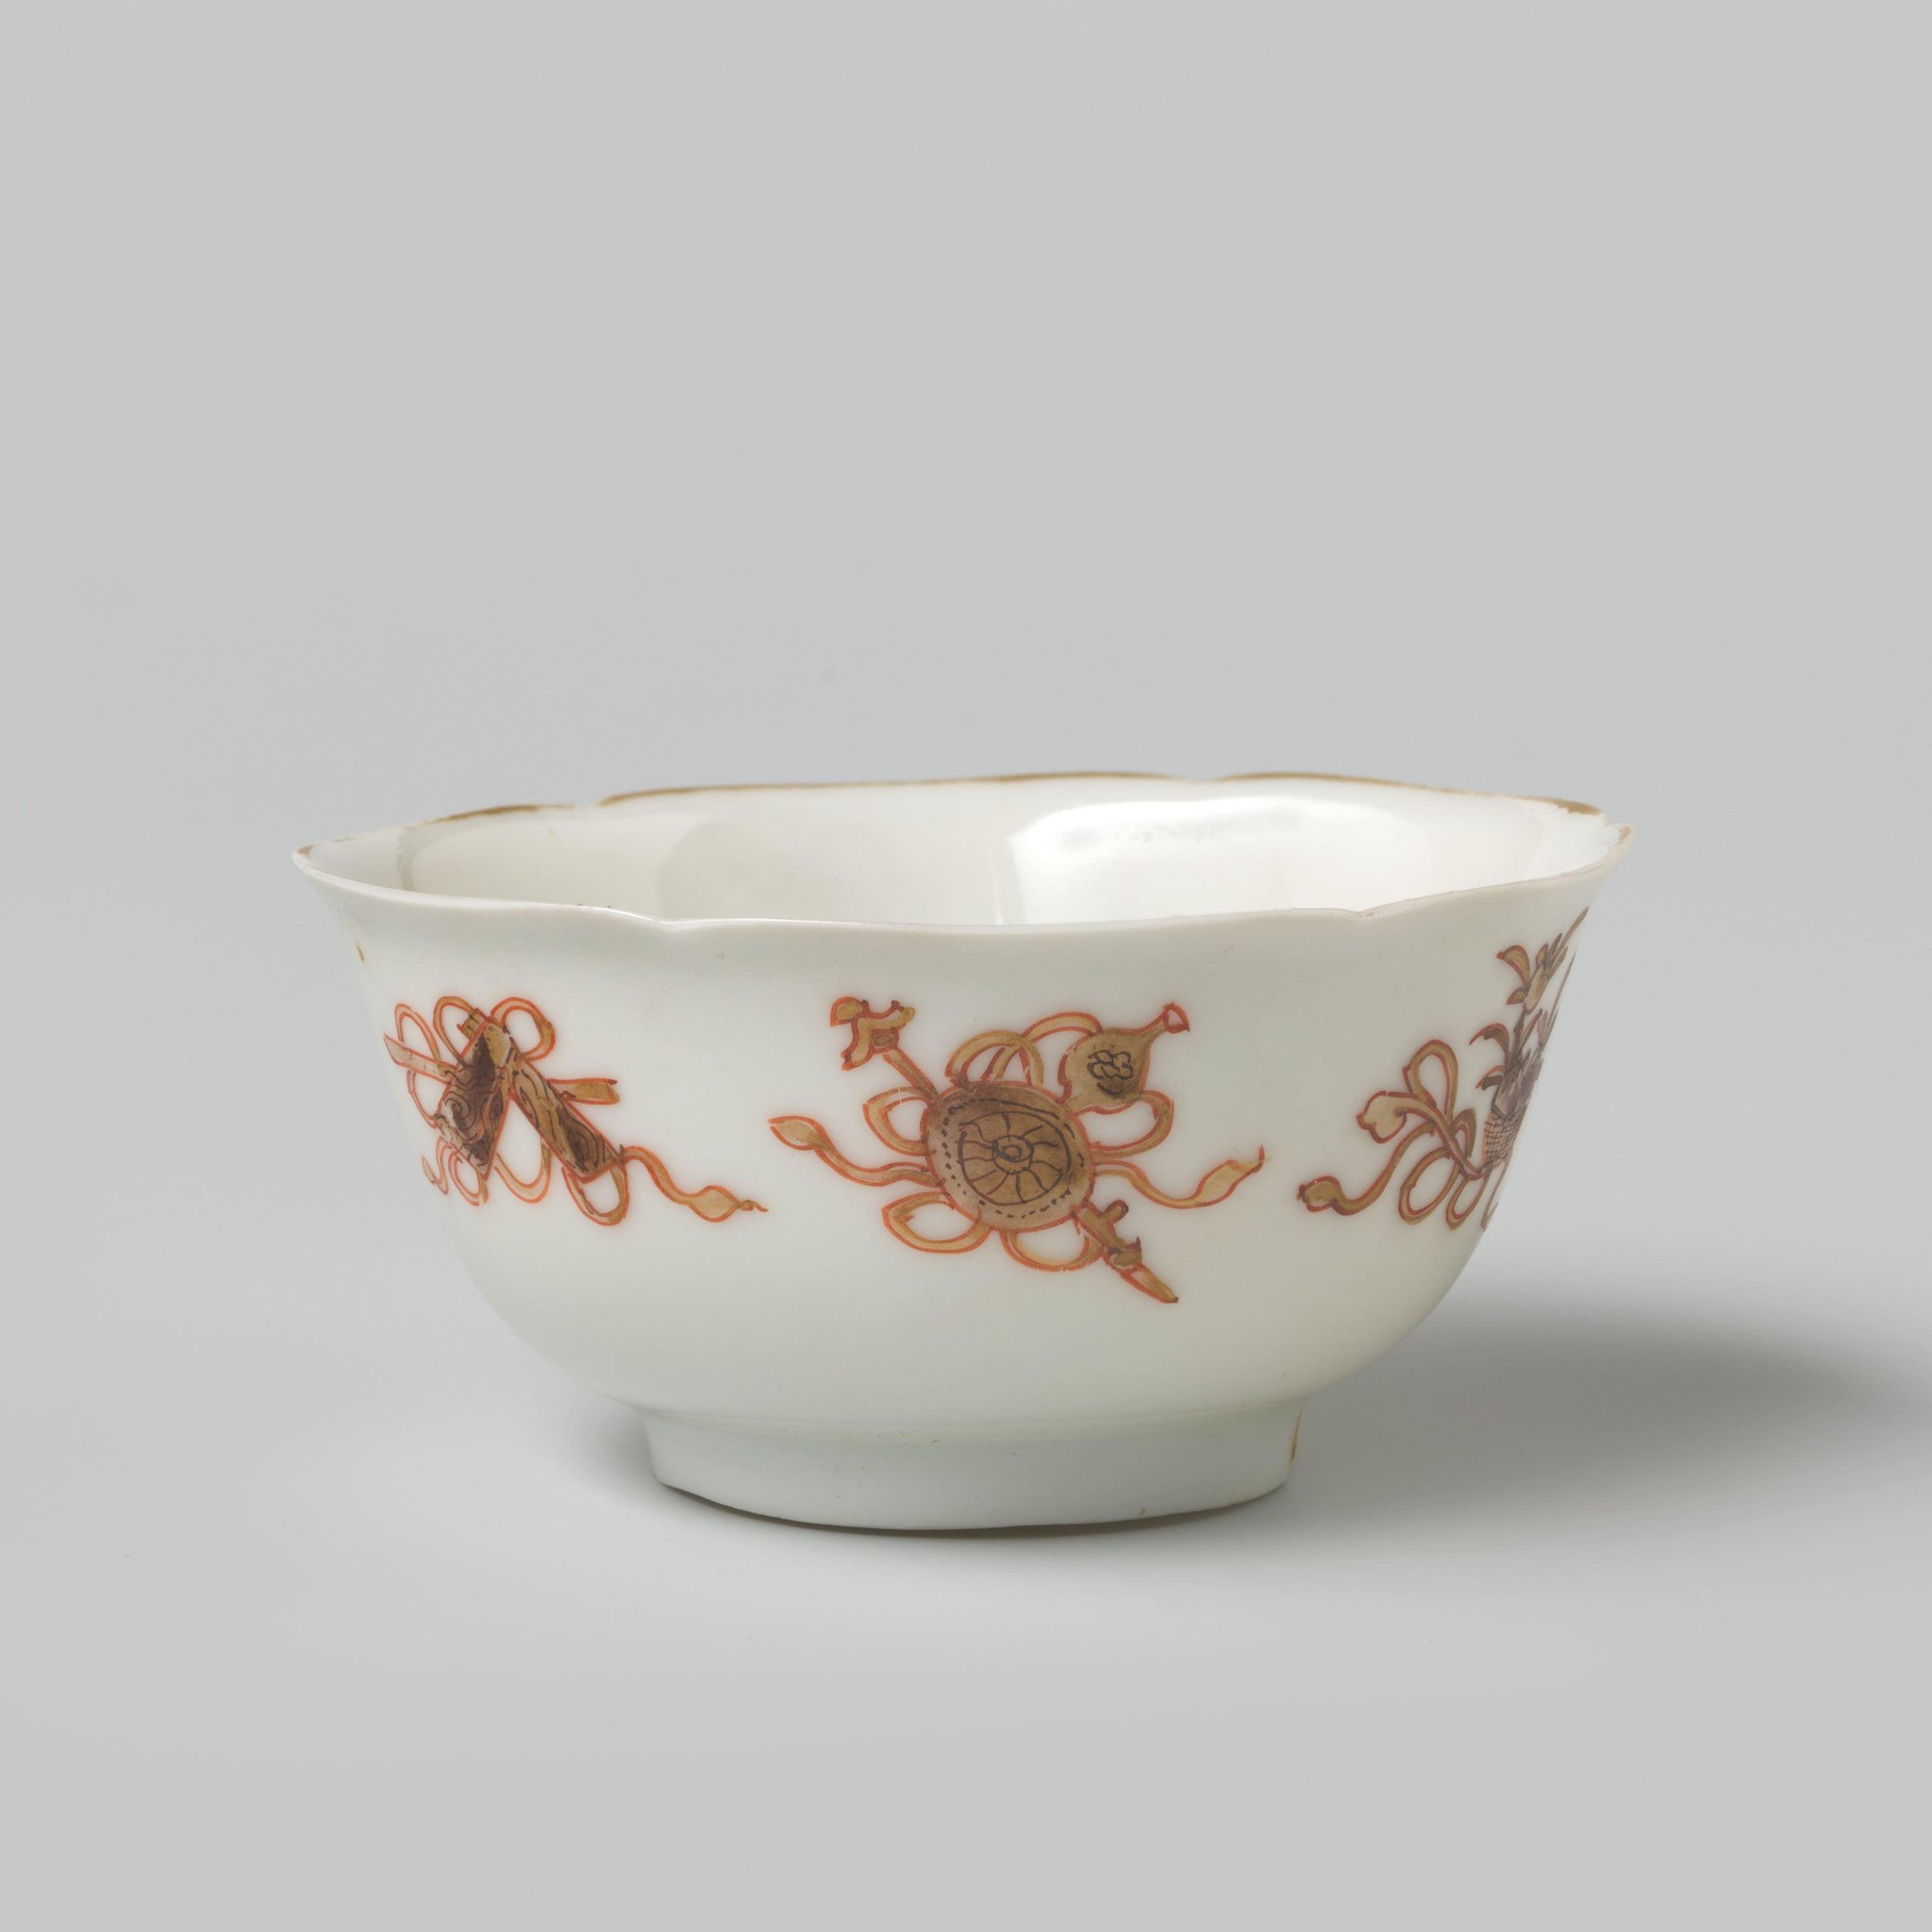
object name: cup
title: Cup with taoist symbols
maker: Anonymous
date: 1700-1724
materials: glaze, paint, porcelain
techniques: firing, gilding, turning, vitrification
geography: china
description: Kop van porselein met zesmaal gelobde rand, beschilderd op het glazuur in rood en goud. Een bloemenmand met paddestoelen (lingzhi), hieromheen de acht taoïstische symbolen (kalebas, fluit, castagnetten, slaginstrument, lotus, waaier, zwaard, fruitmand) afgebeeld. Bodem van de kop met barsten. Melk en bloed.